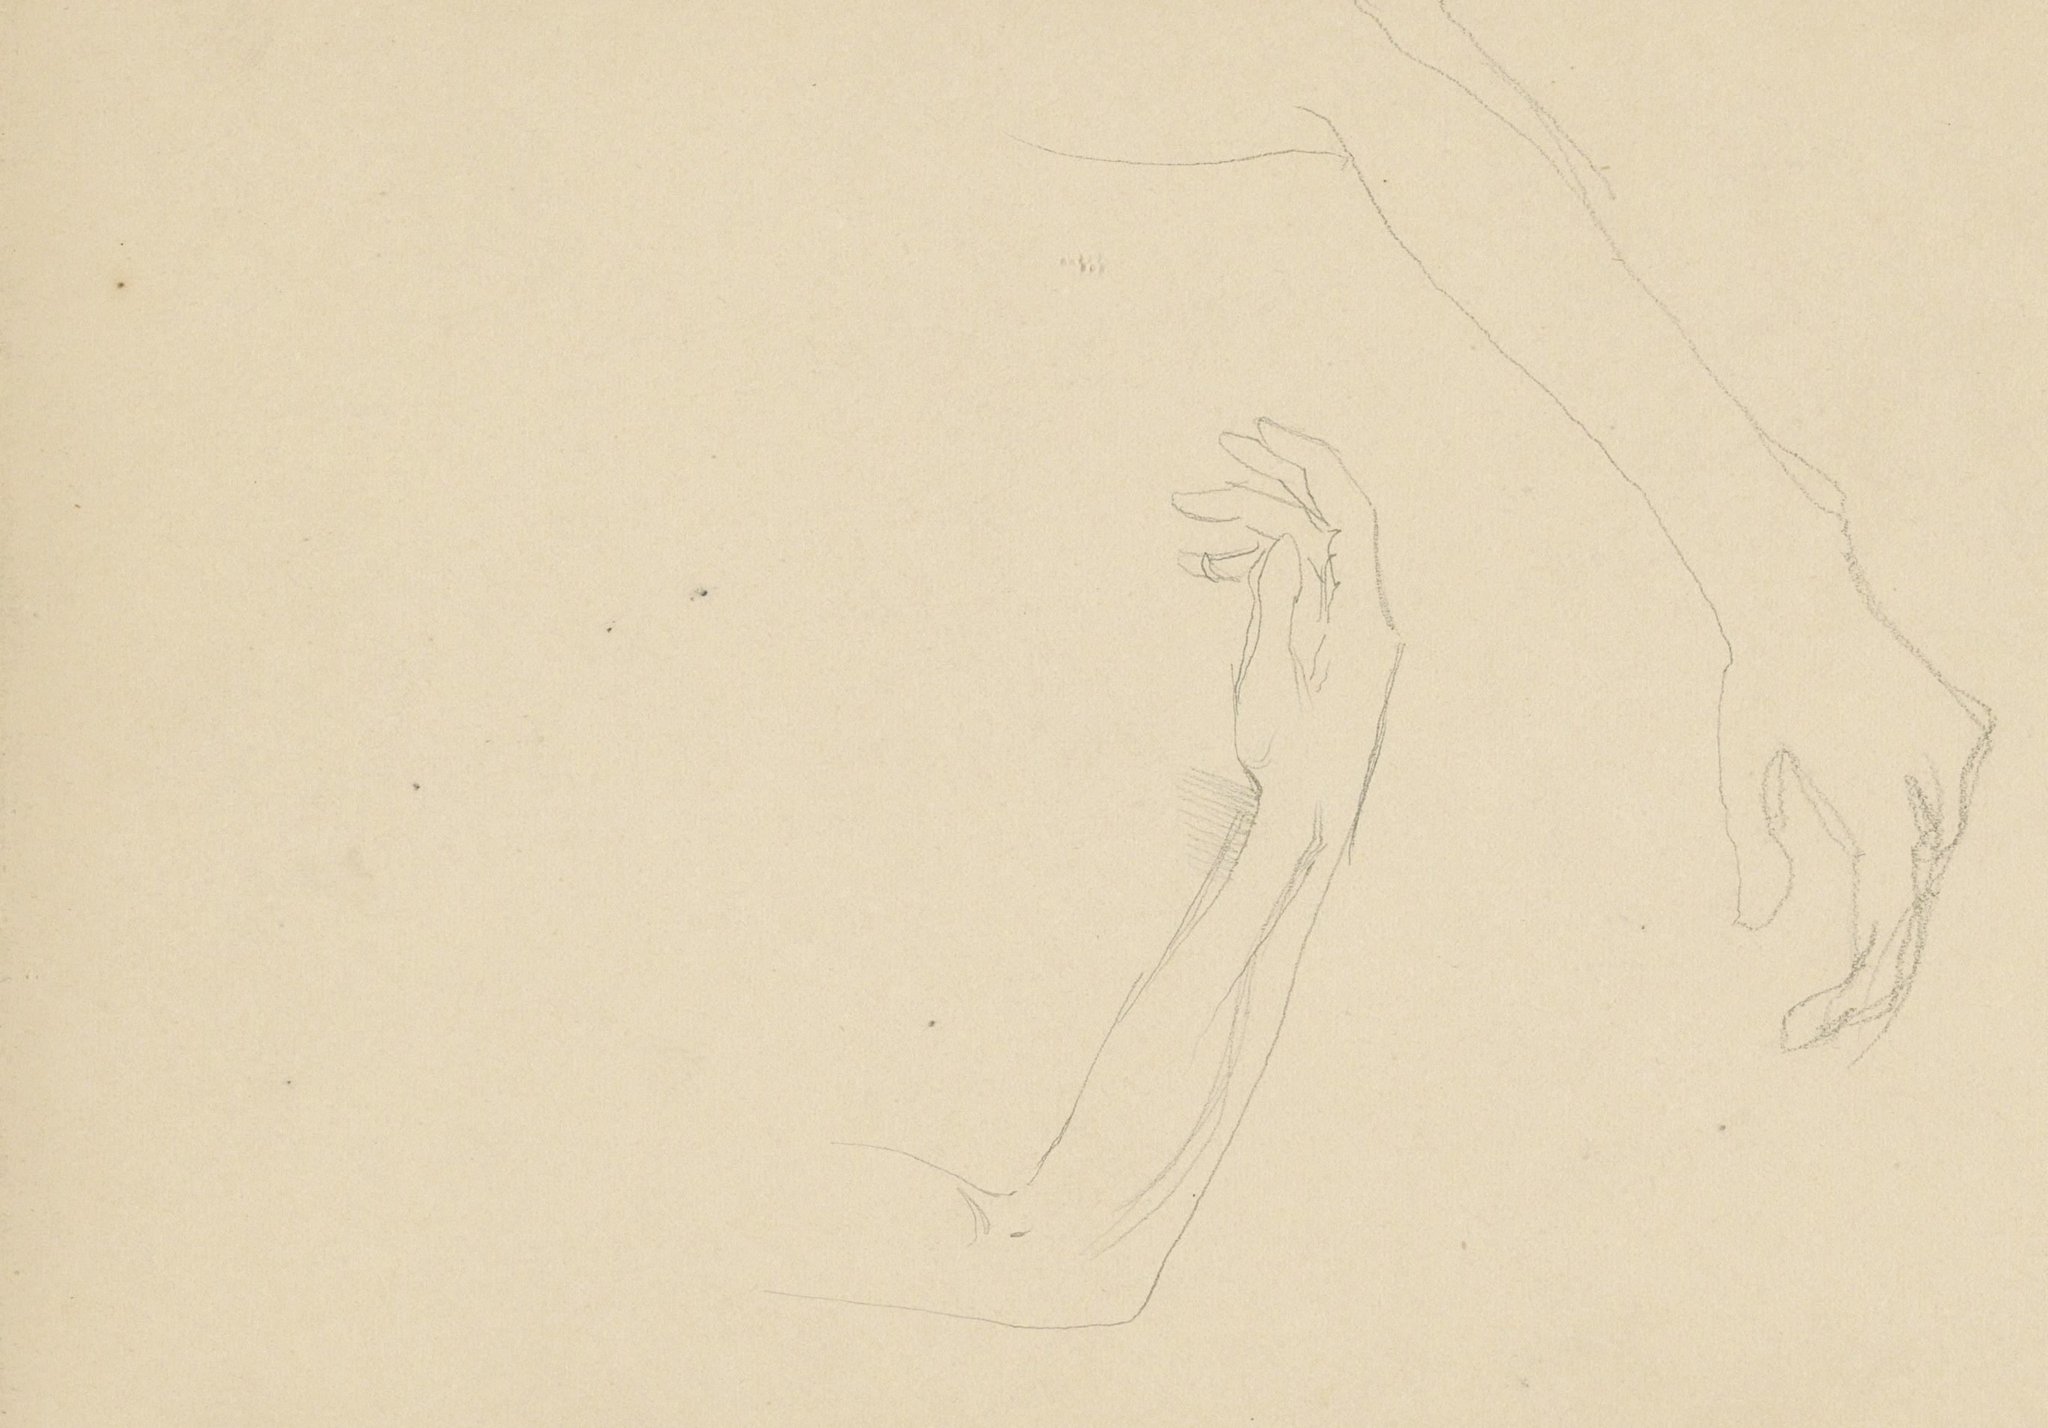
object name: sketchbook leaf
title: Armen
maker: antoon derkinderen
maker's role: draughtsman, painter, print maker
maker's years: 1859-1925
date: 1869-1925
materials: paper, pencil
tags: arms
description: Blad 7 recto uit een schetsboek met 28 bladen.